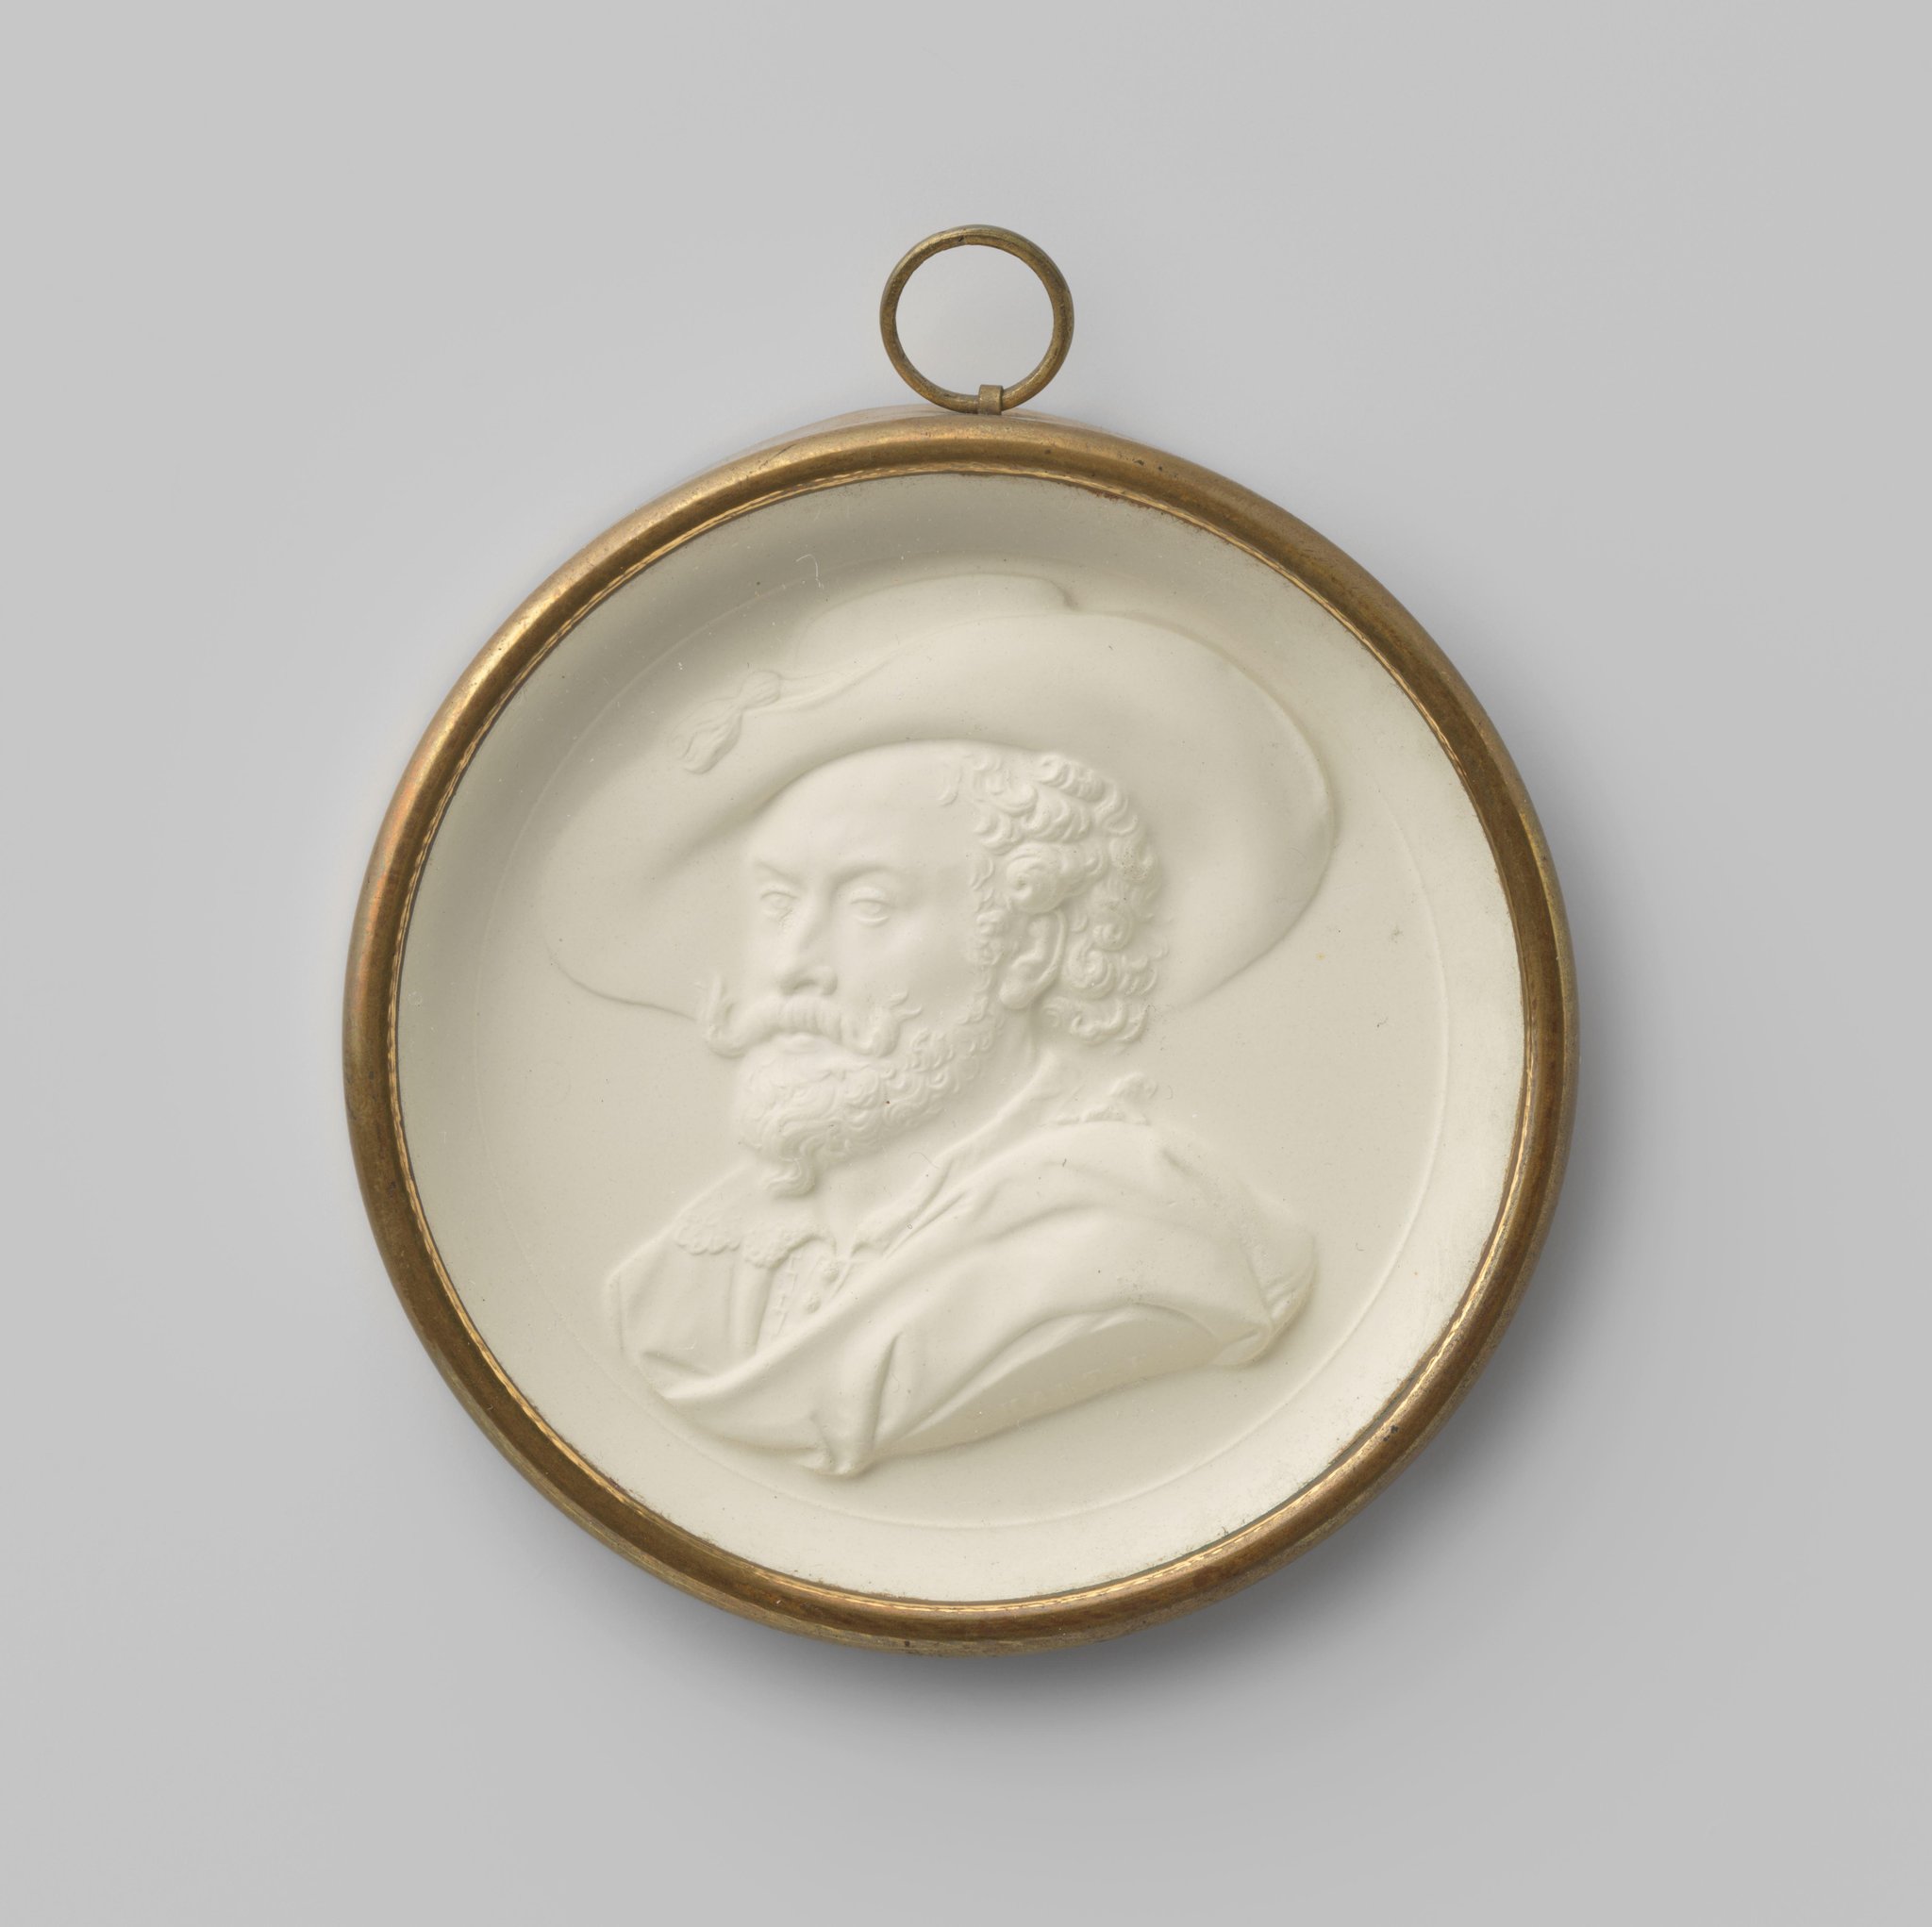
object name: locket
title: Pieter Paul Rubens, Vlaams schilder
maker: gottfried eichler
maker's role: draughtsman, painter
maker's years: 1677-1757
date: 1840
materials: brass, glass, gypsum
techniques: casting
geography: berlin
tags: antwerp, painter, print maker, draughtsman, peter paul rubens, portrait, self-portrait of painter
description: Eenzijdig medaillon in messing ring achter glas aan draagoog en draagring. Voorzijde: borststuk man met hoed naar links. Keerzijde: etiket met opschrift.